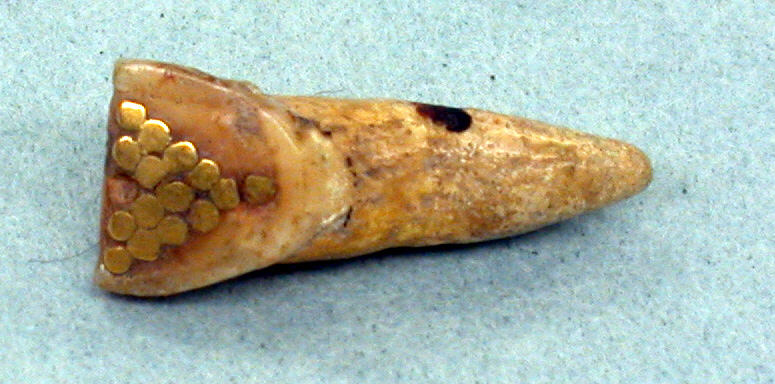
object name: tooth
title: Inlaid Tooth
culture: mindanao or visayan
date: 1301-1500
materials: gold, pigment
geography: philippines